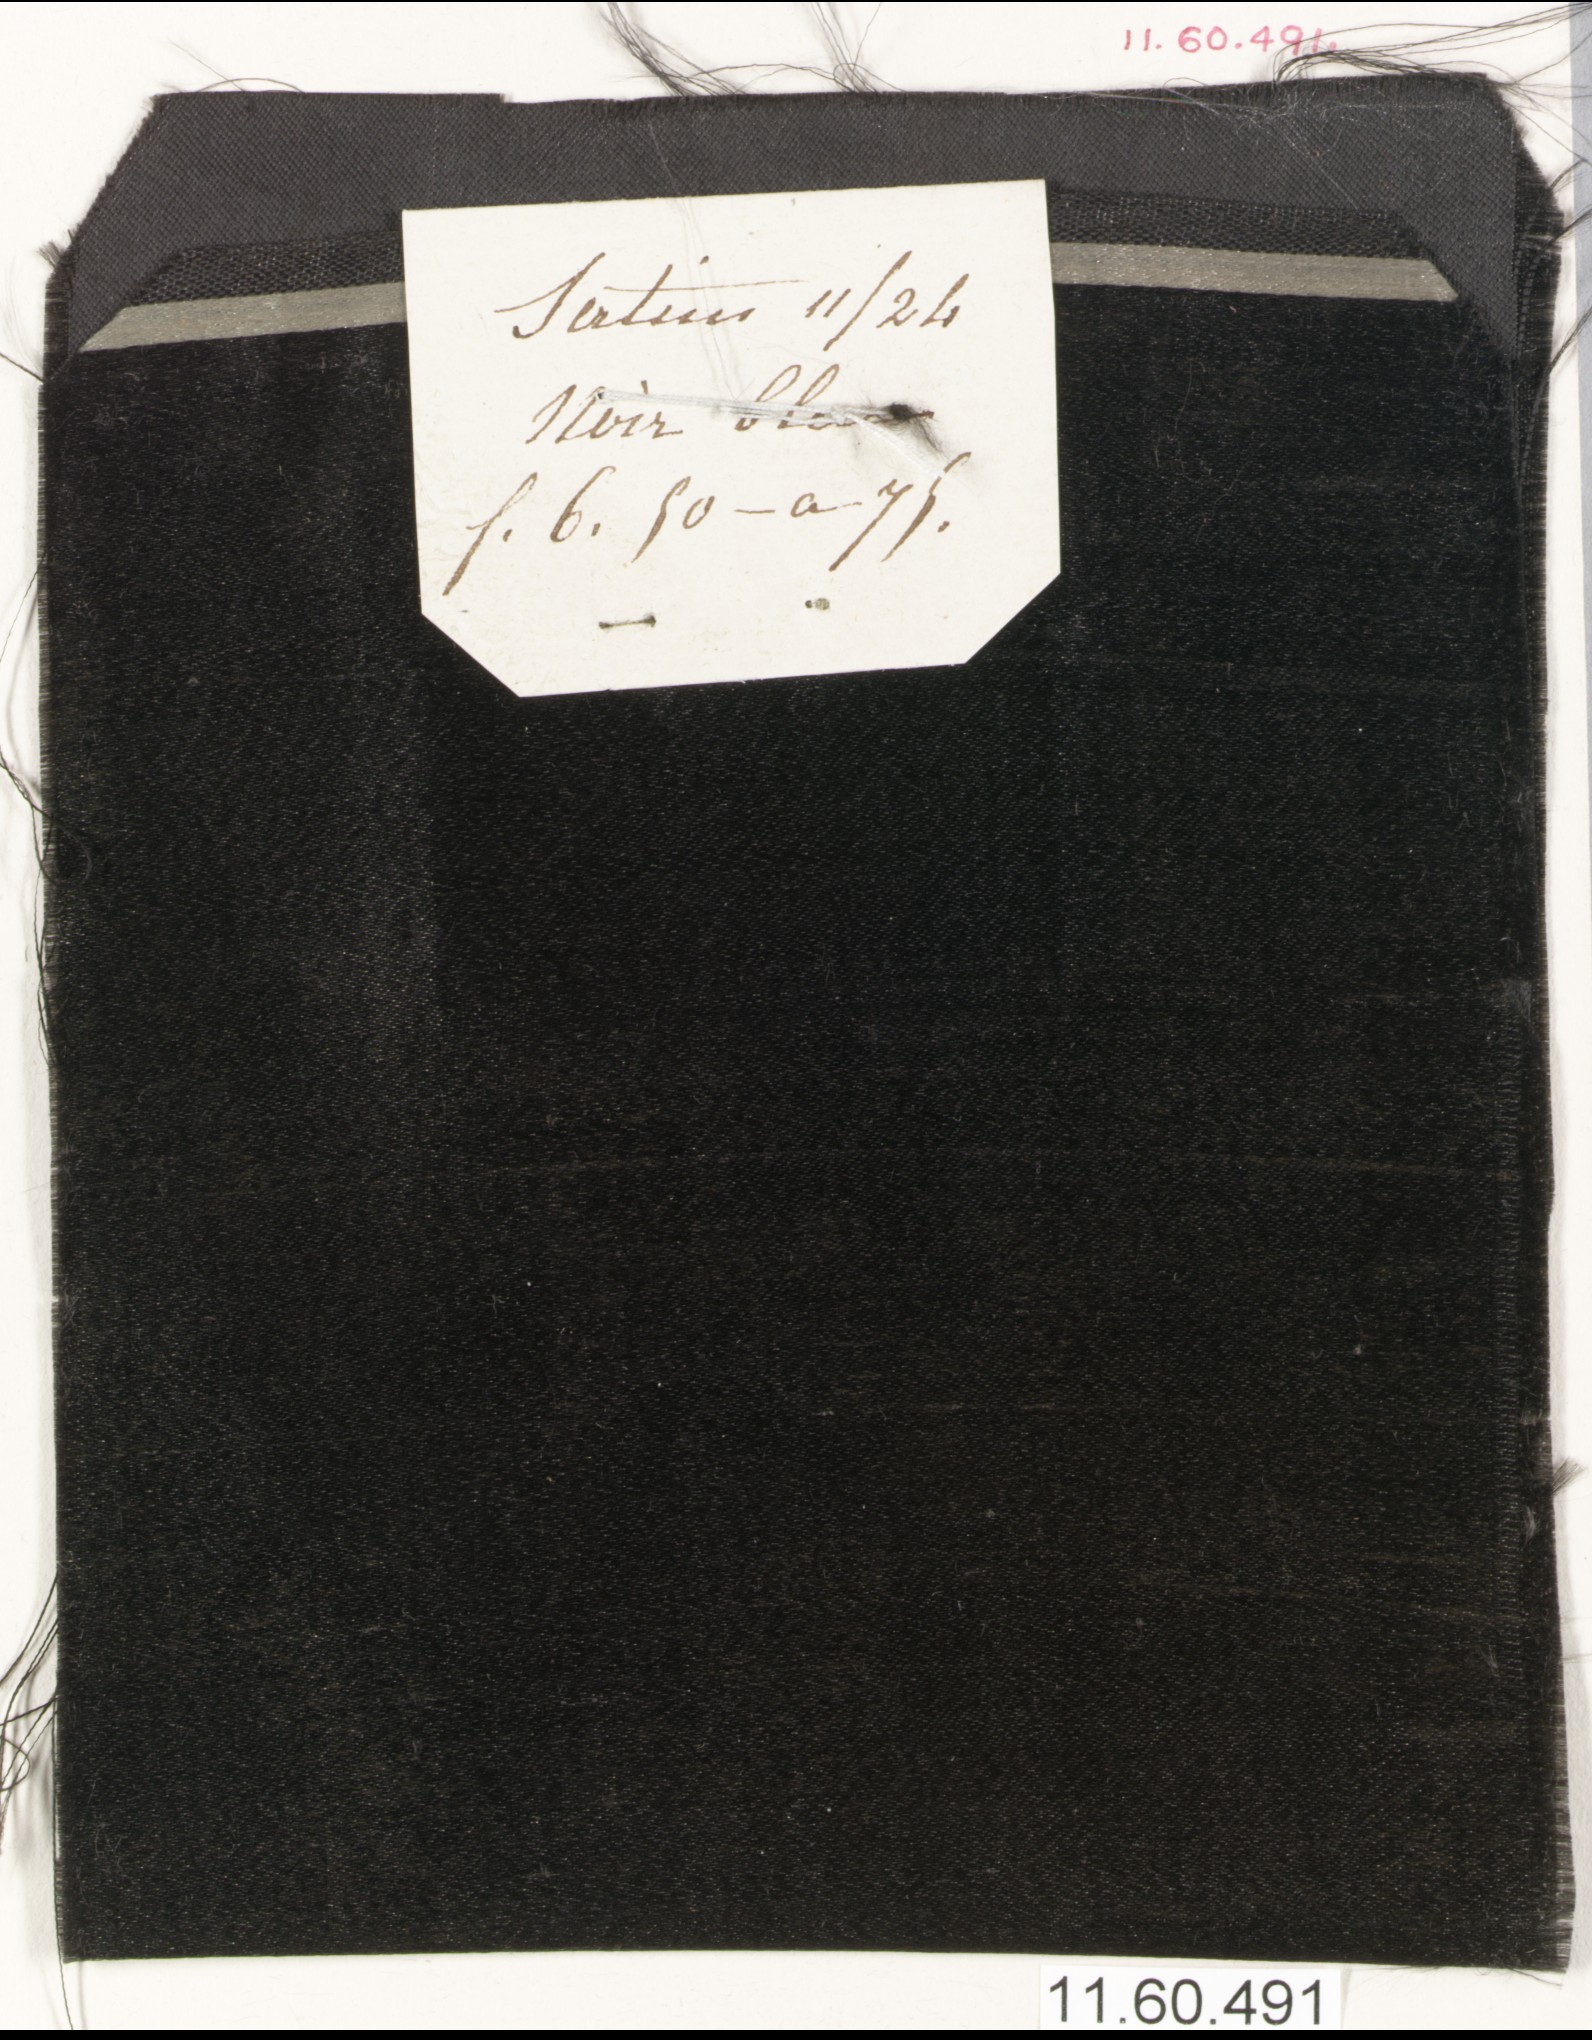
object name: sample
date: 1801-1850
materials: silk